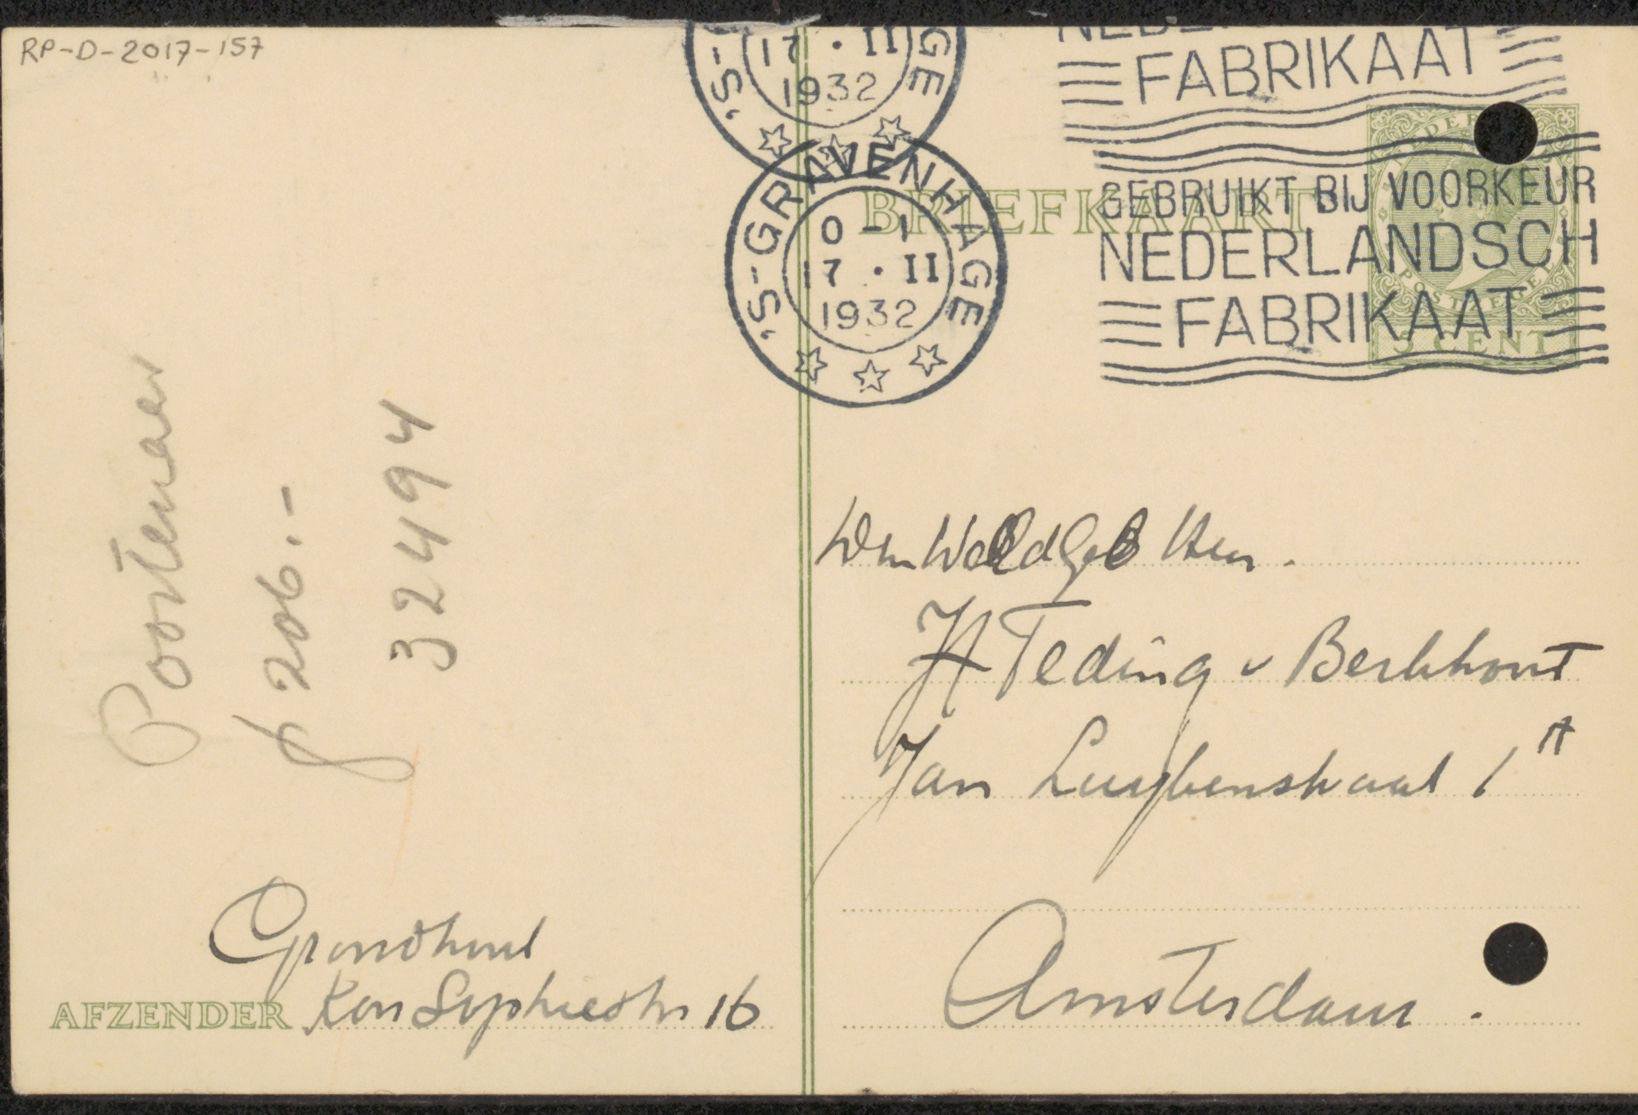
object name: postcard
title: Briefkaart aan jonkheer Hendrik Teding van Berkhout (1879-1969)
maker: willem adrianus grondhout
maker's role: draughtsman, painter, print maker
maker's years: 1878-1934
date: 1932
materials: cardboard, ink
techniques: pen, writing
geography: the hague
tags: haarlem, amsterdam, jonkheer hendrik teding van berkhout (1879-1969), money